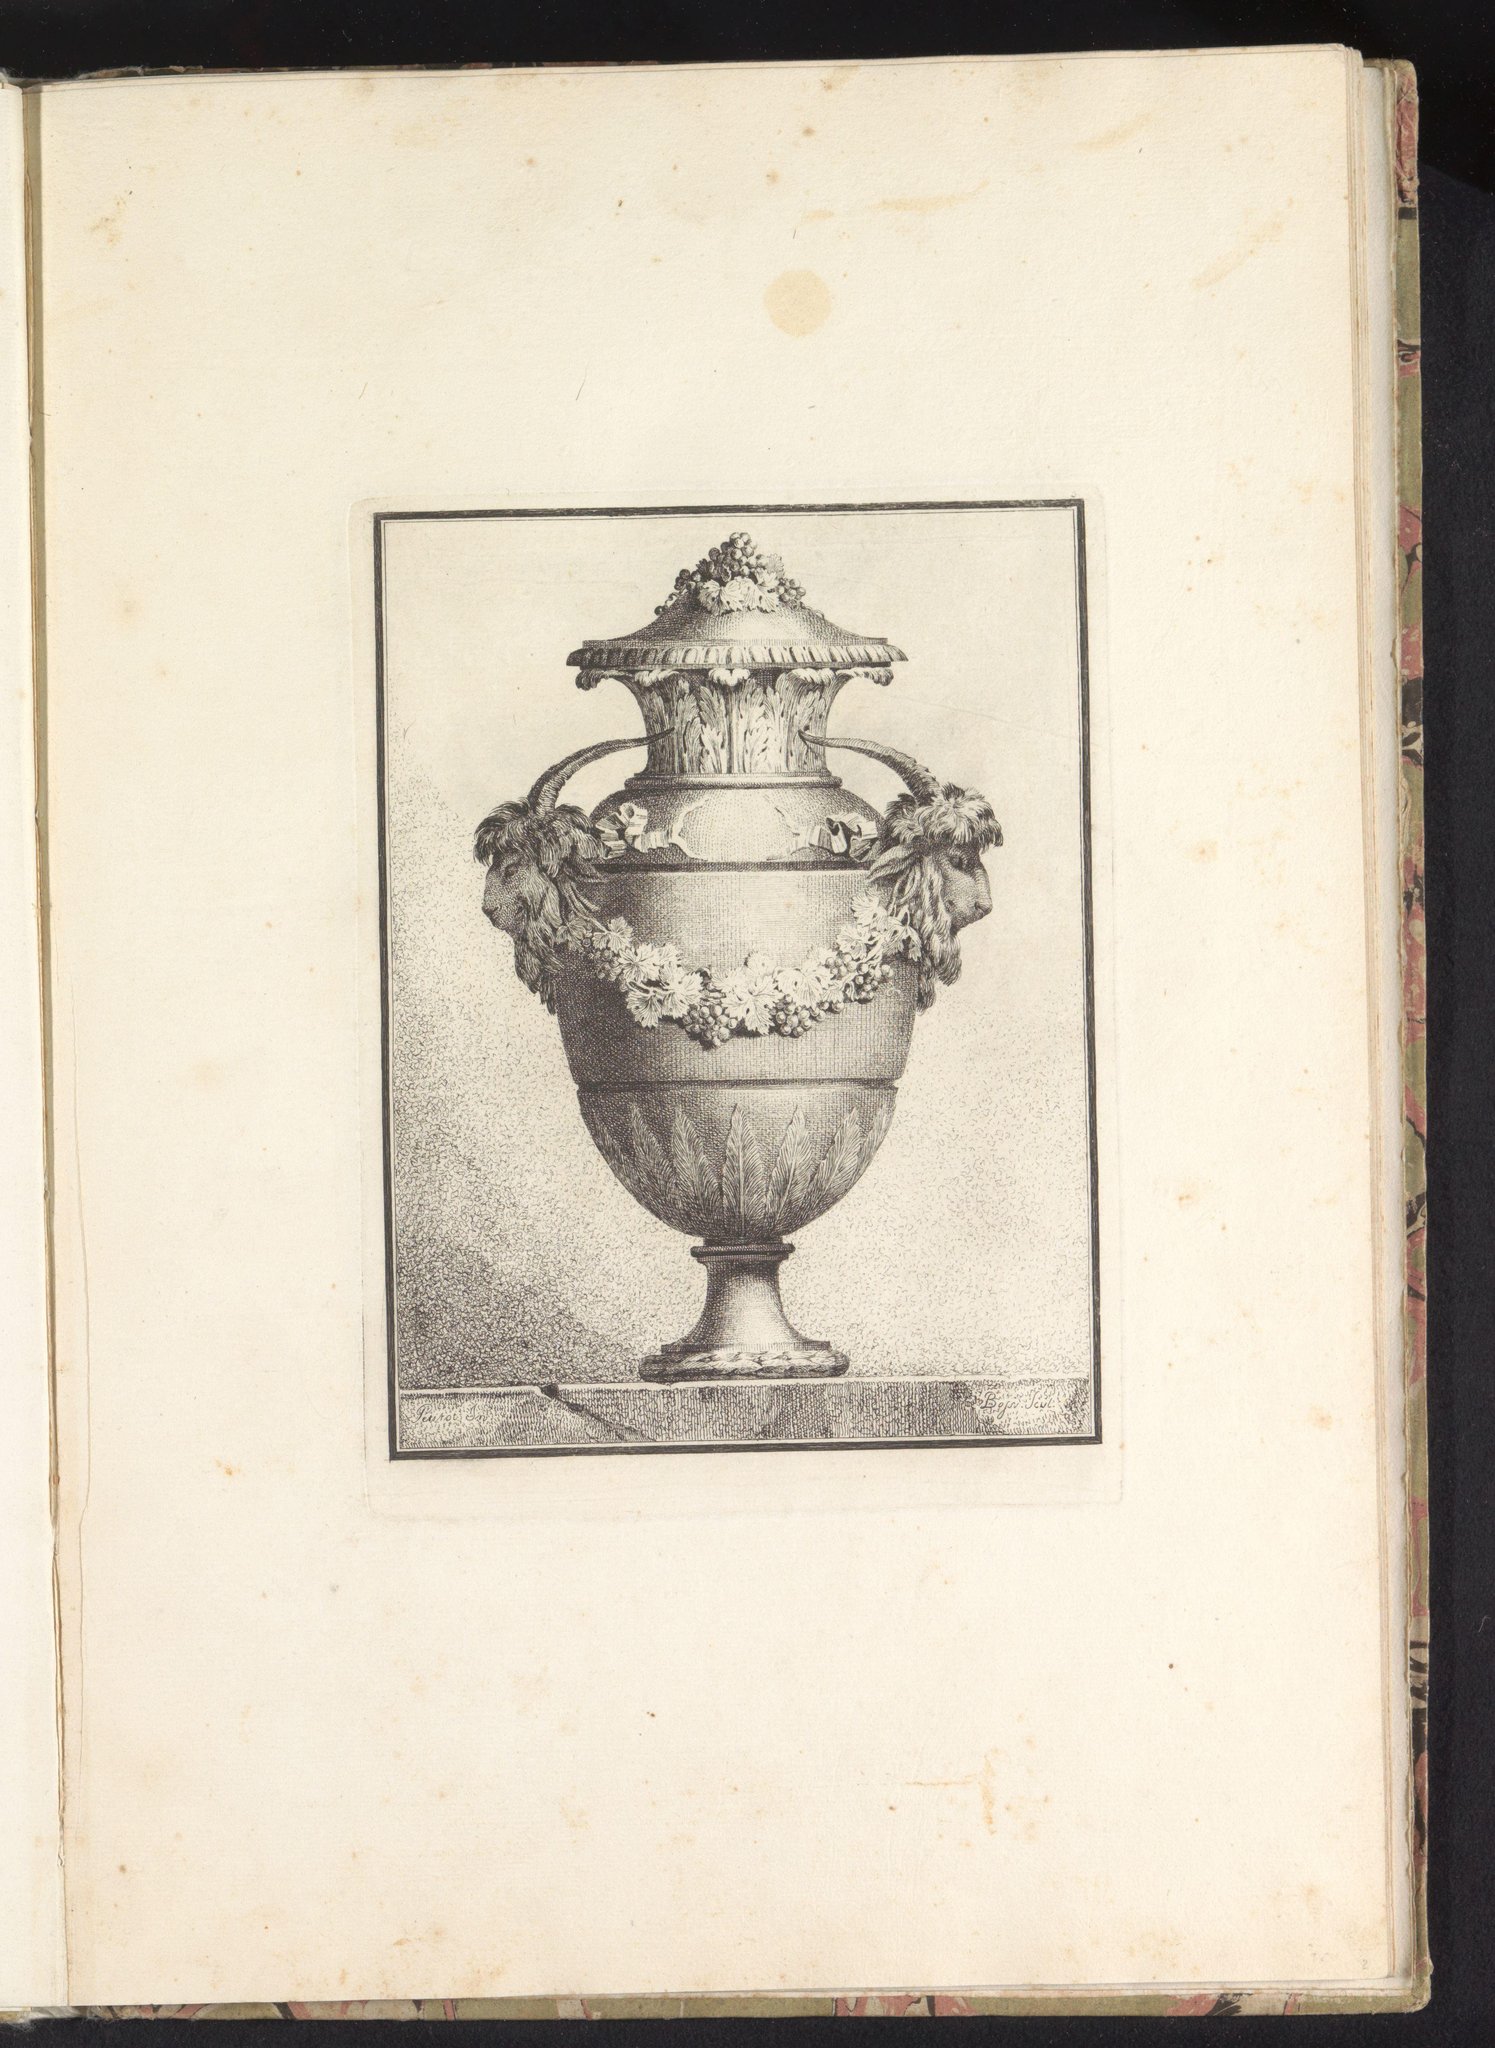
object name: ornament print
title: Vaas met deksel en twee ramskoppen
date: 1764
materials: paper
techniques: etching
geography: parma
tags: ram's head ~ ornament, vase ~ ornament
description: Vaas met deksel waarop druivenranken. De oren van de vaas worden gevormd door twee ramskoppen. De buik is gedecoreerd met druivenranken. De vaas staat op een muur. No. 3 uit serie van 31. Prent maakt deel uit van een album. Gedrukt recto rechtsboven: 3.